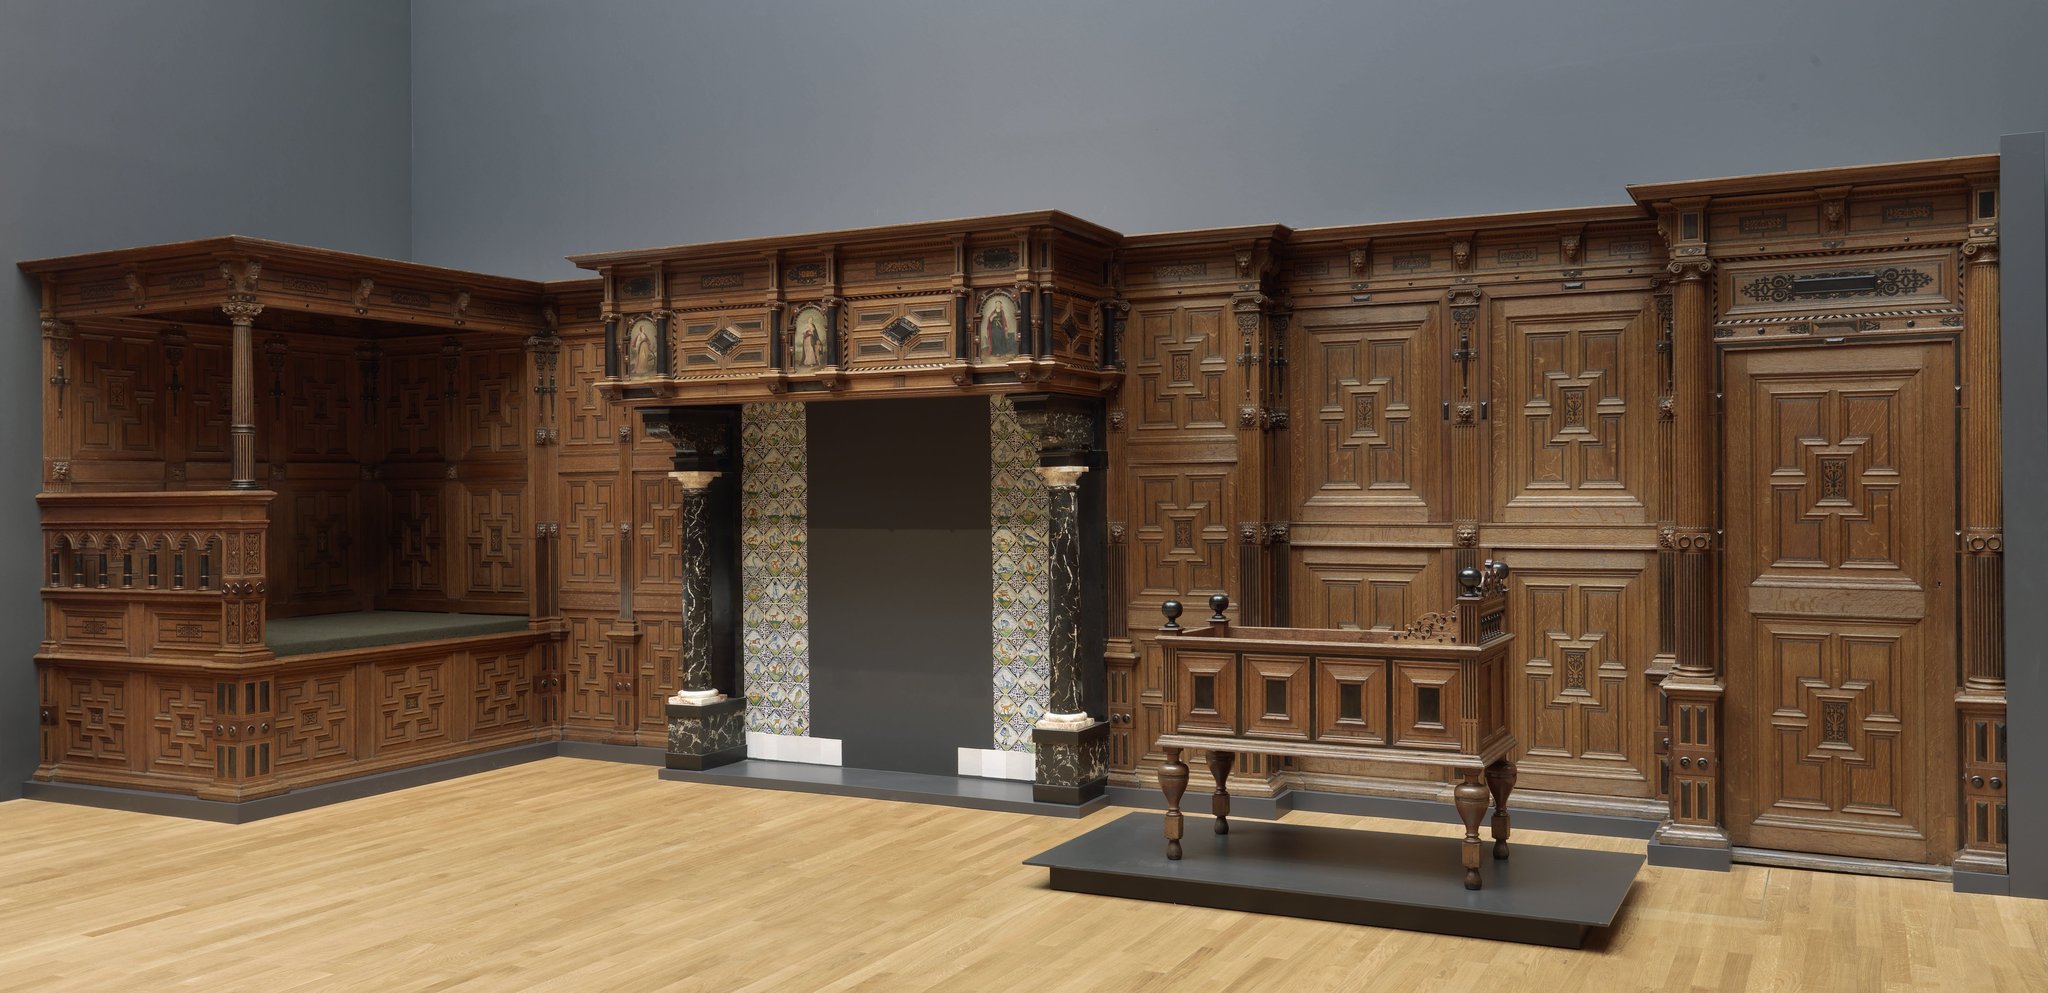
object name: interieuronderdeel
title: Schoorsteenmantel en betimmeringen van hout, onderdeel van betimmering 1617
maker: Anonymous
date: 1617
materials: wood, stone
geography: northern netherlands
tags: dordrecht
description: De schoorsteenmantel van eikenhout, versierd met ebbenhout en andere houtsoorten, steunend op twee consoles gedragen door zandstenen grijsgeverfde kariatiden op een voetstuk. Het mantelfries heeft in het midden en op de hoeken een boogstelling, waarin een obelisk van satijnhout op voetstuk bekroond met een geschaduwde bol. De boogstellingen zijn geflankeerd door vlakke pilasters met cannelures en versierd met palmhouten diamantkopjes en zwart-eiken gespen met gezwarte druipers. De liggende panelen tussen de boogstellingen hebben cornissingen met zwart-eiken moresken als middenstuk. Het hoofdgestel is geleed door consoles met dierenmaskers, die geplaatst zijn boven de pilaster en de ver uitspringende kroonlijst steunen. De zijkanten hebben ieder één liggend paneel.